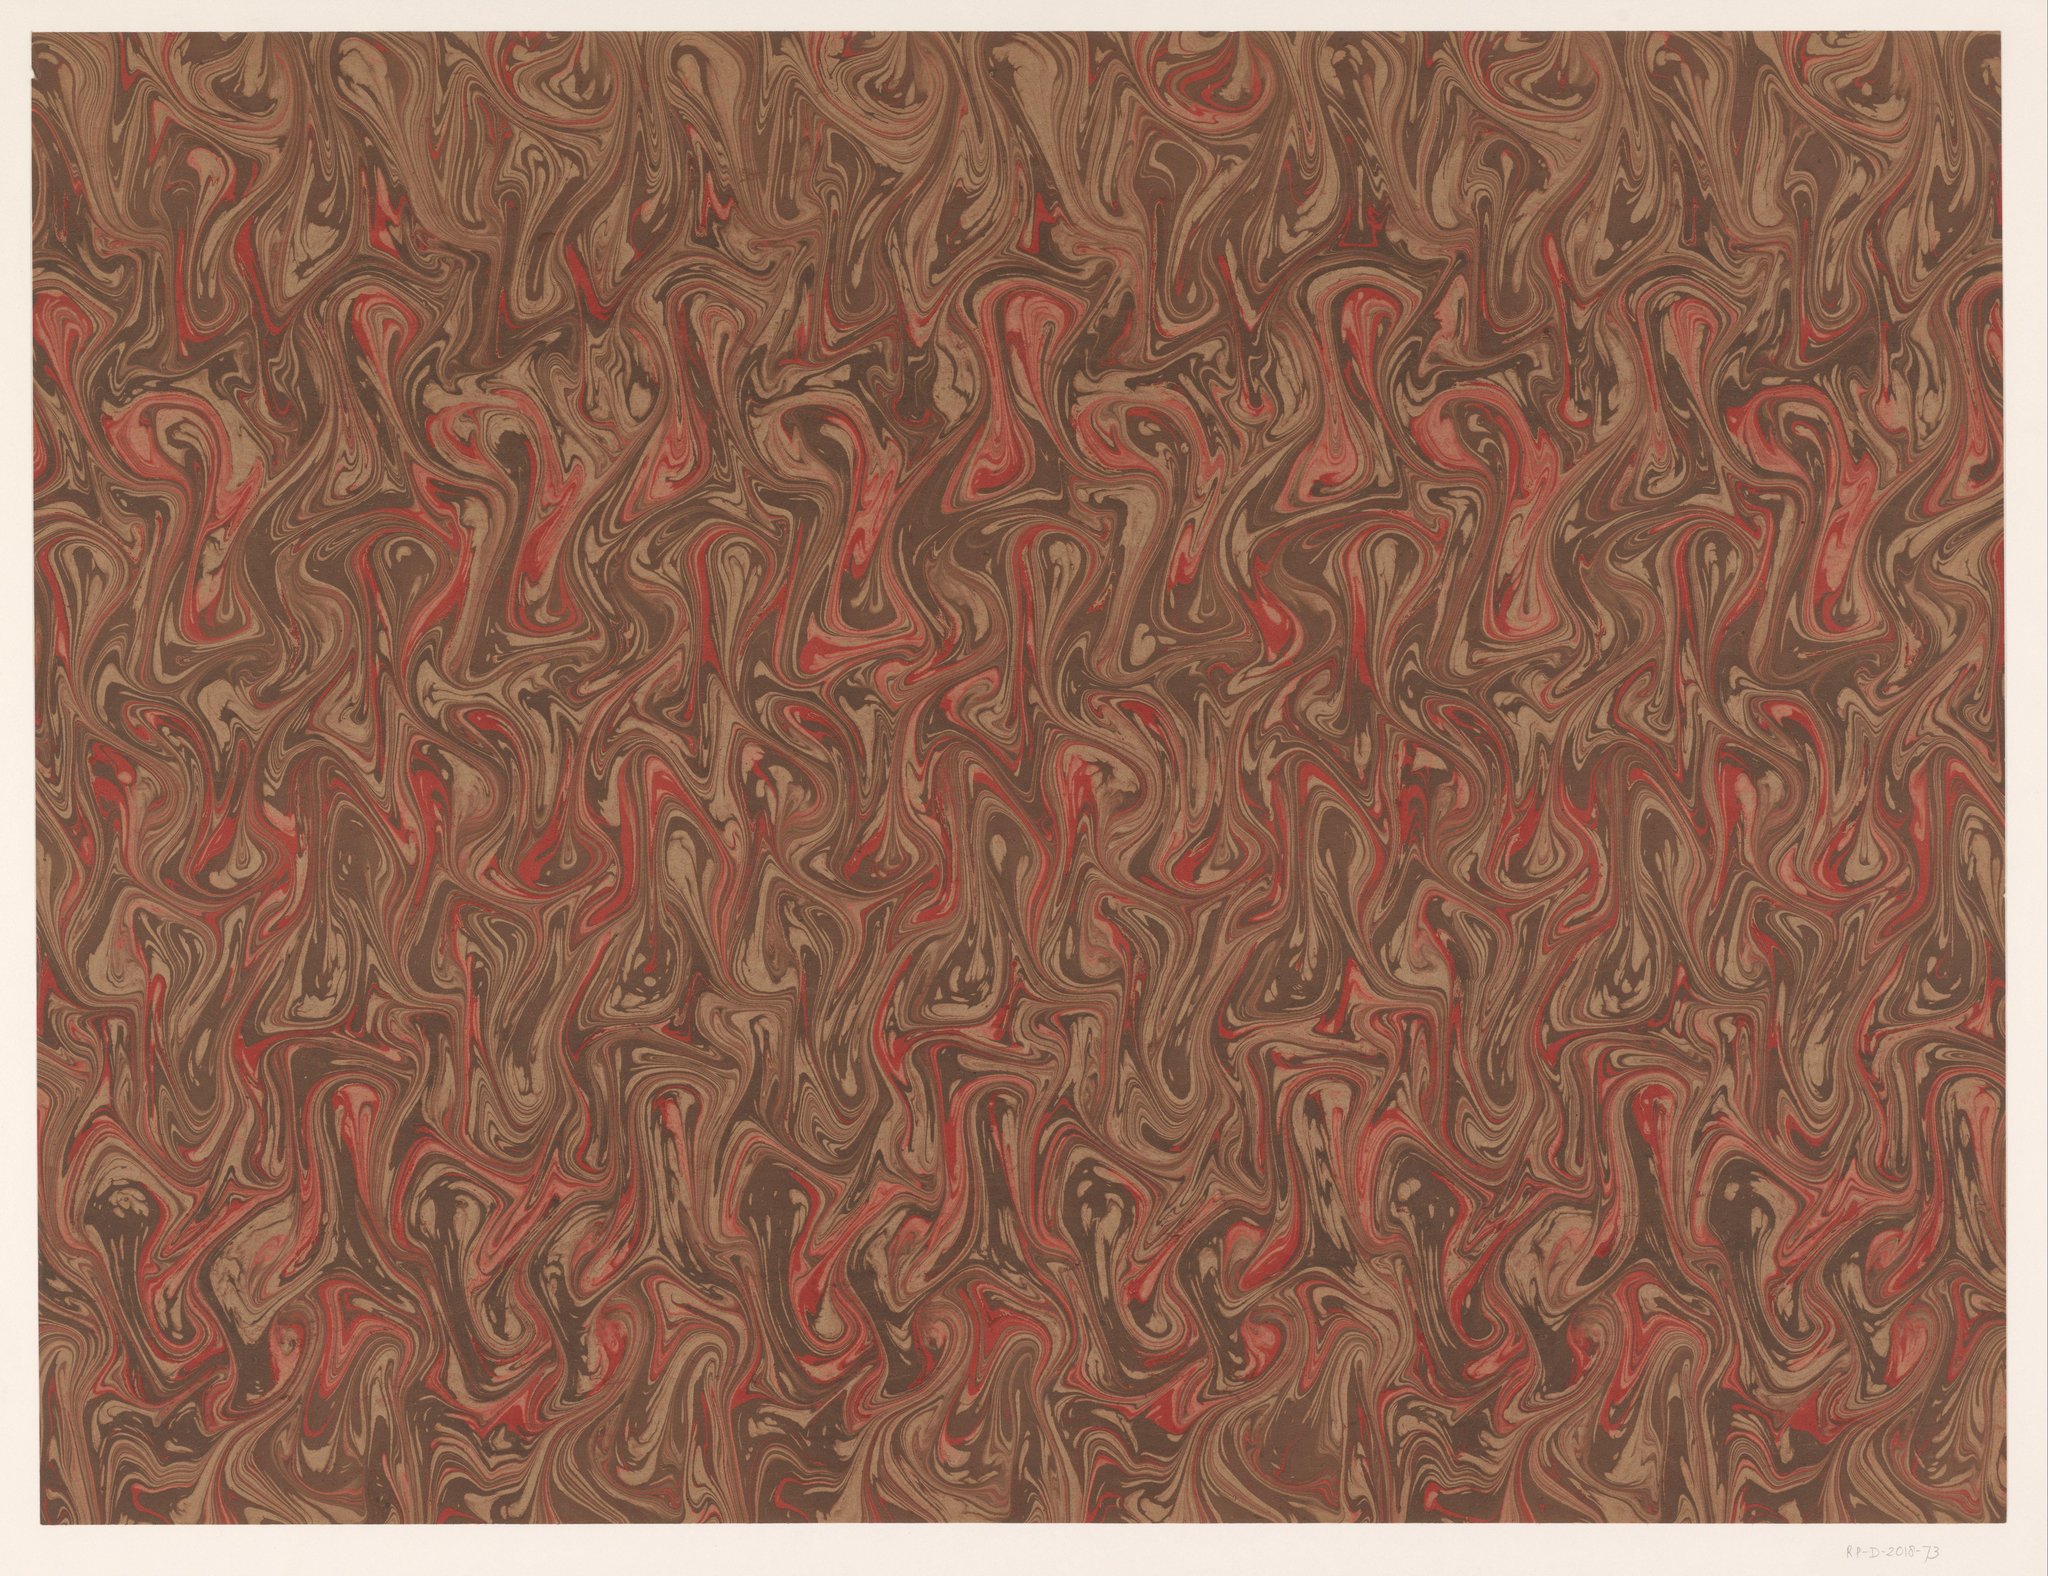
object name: marbled paper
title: Fantasiemarmer in rood en bruin op bruin papier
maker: Anonymous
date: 1900-2000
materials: paint, paper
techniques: marbled paper